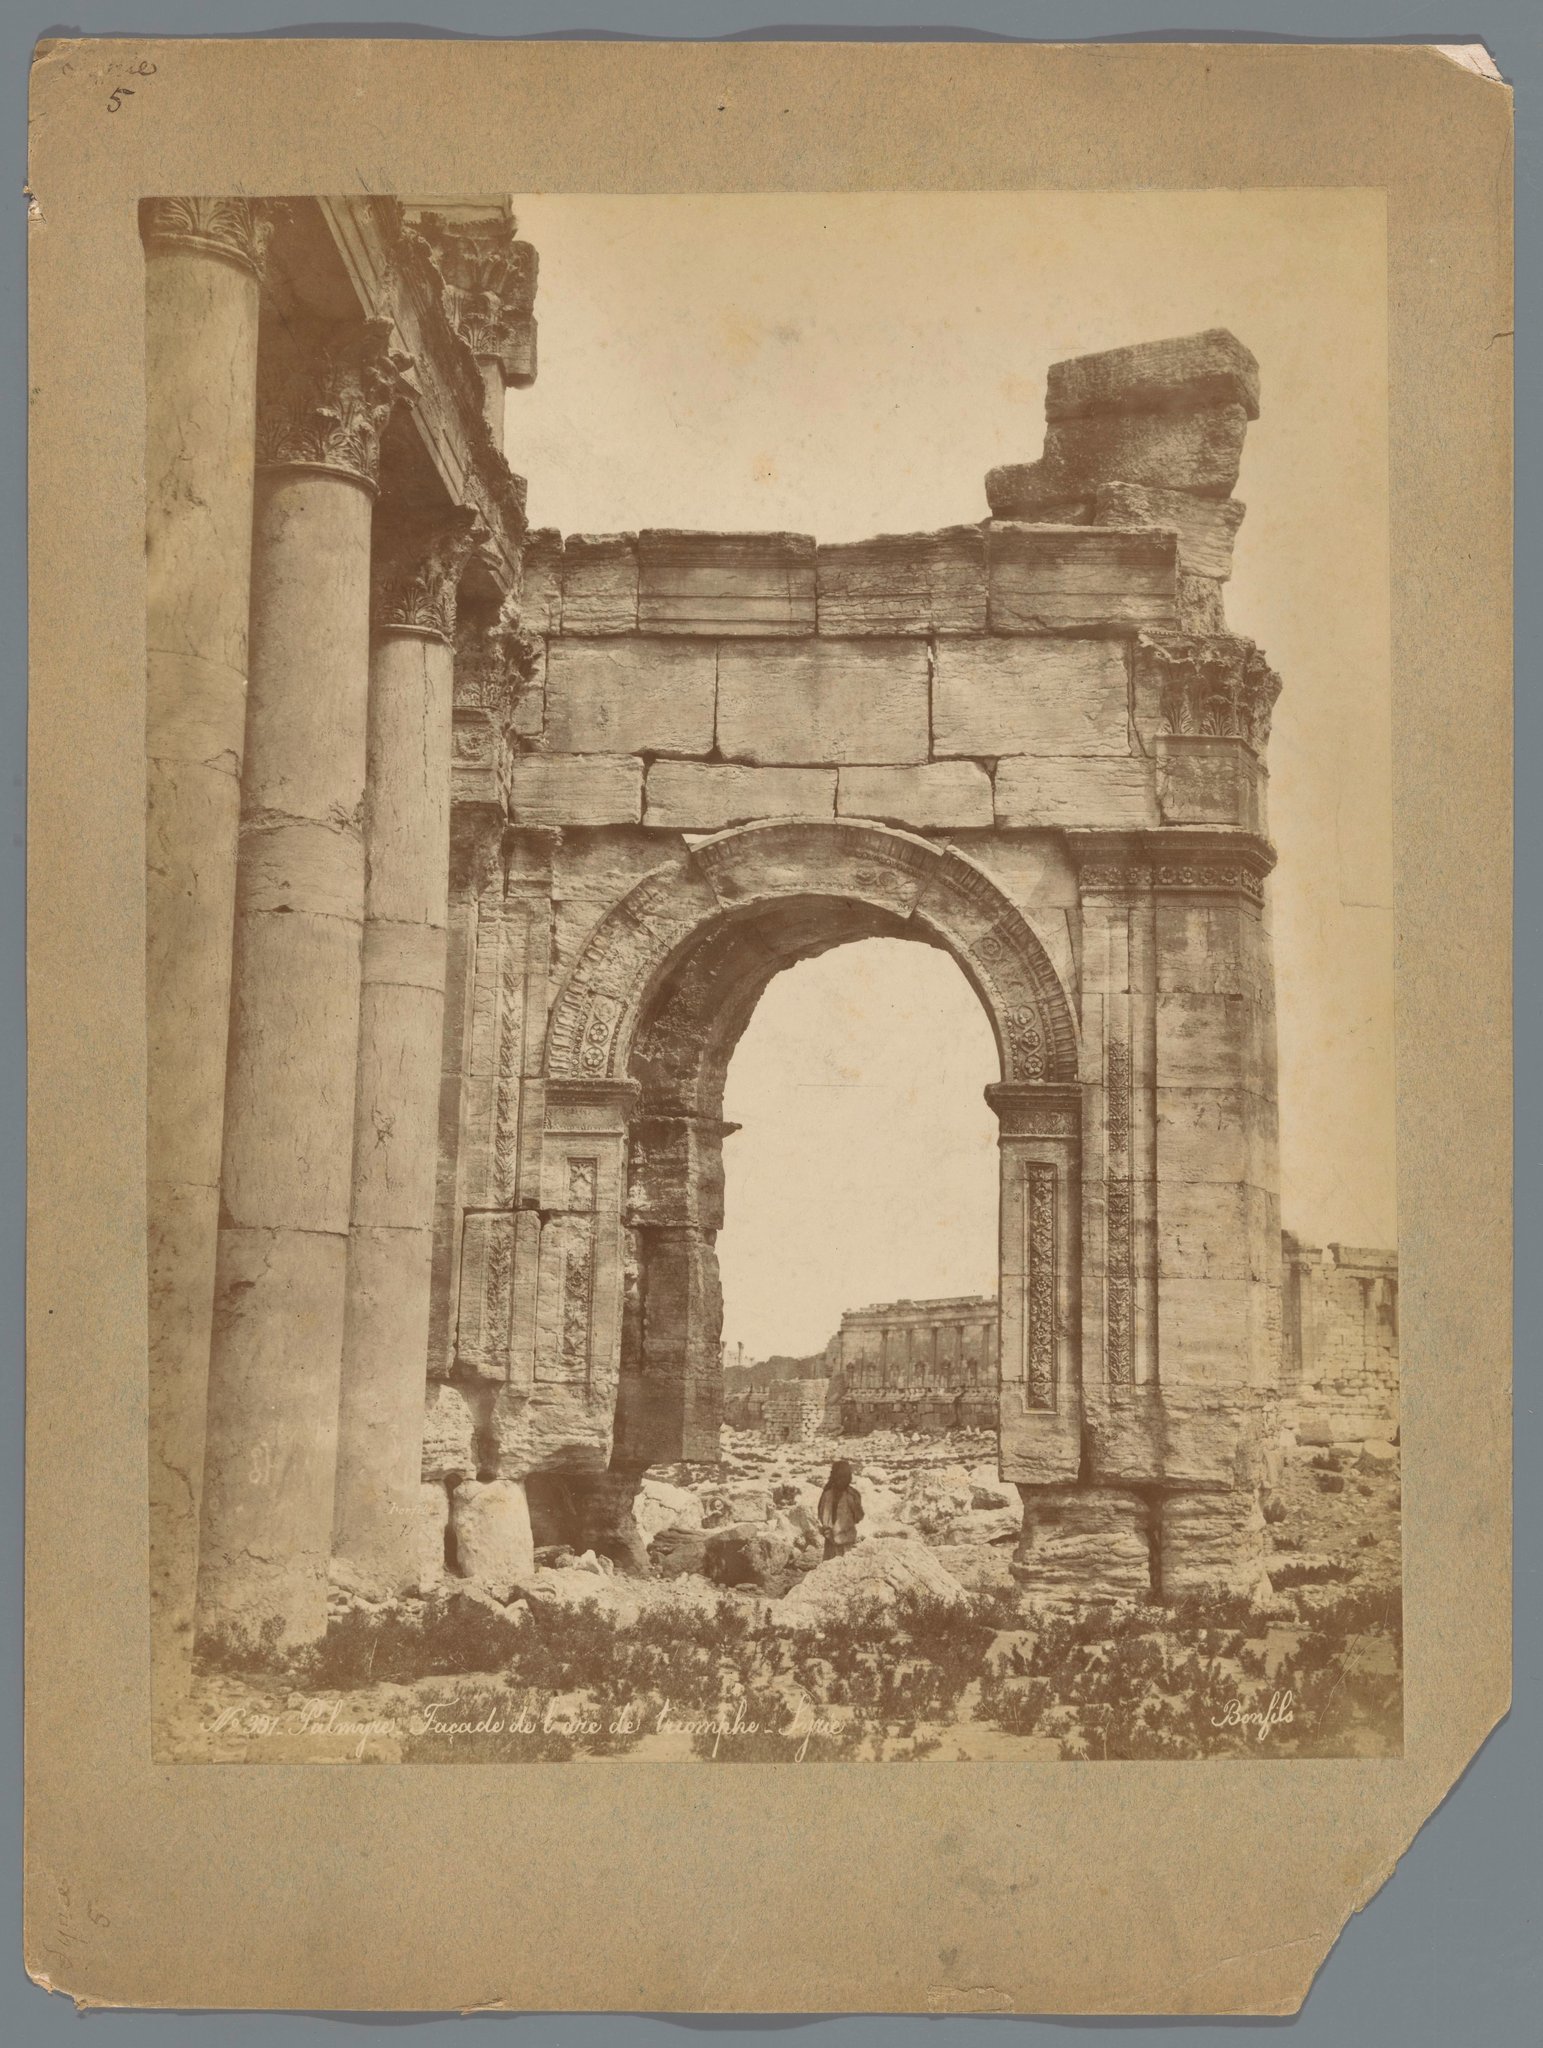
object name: photograph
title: Vooraanzicht van de triomfboog te Palmyra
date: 1875-1900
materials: cardboard, photographic support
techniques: albumen print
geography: palmyra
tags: column, pillar ~ architecture, ruin of a building ~ architecture, triumphal arch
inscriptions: inscription: ‘Syrie 5’, collector's mark: ‘RIJKS-NORMAALSCHOOL voor TEEKENONDERWIJZERS AMSTERDAM’, number: ‘No. 391’